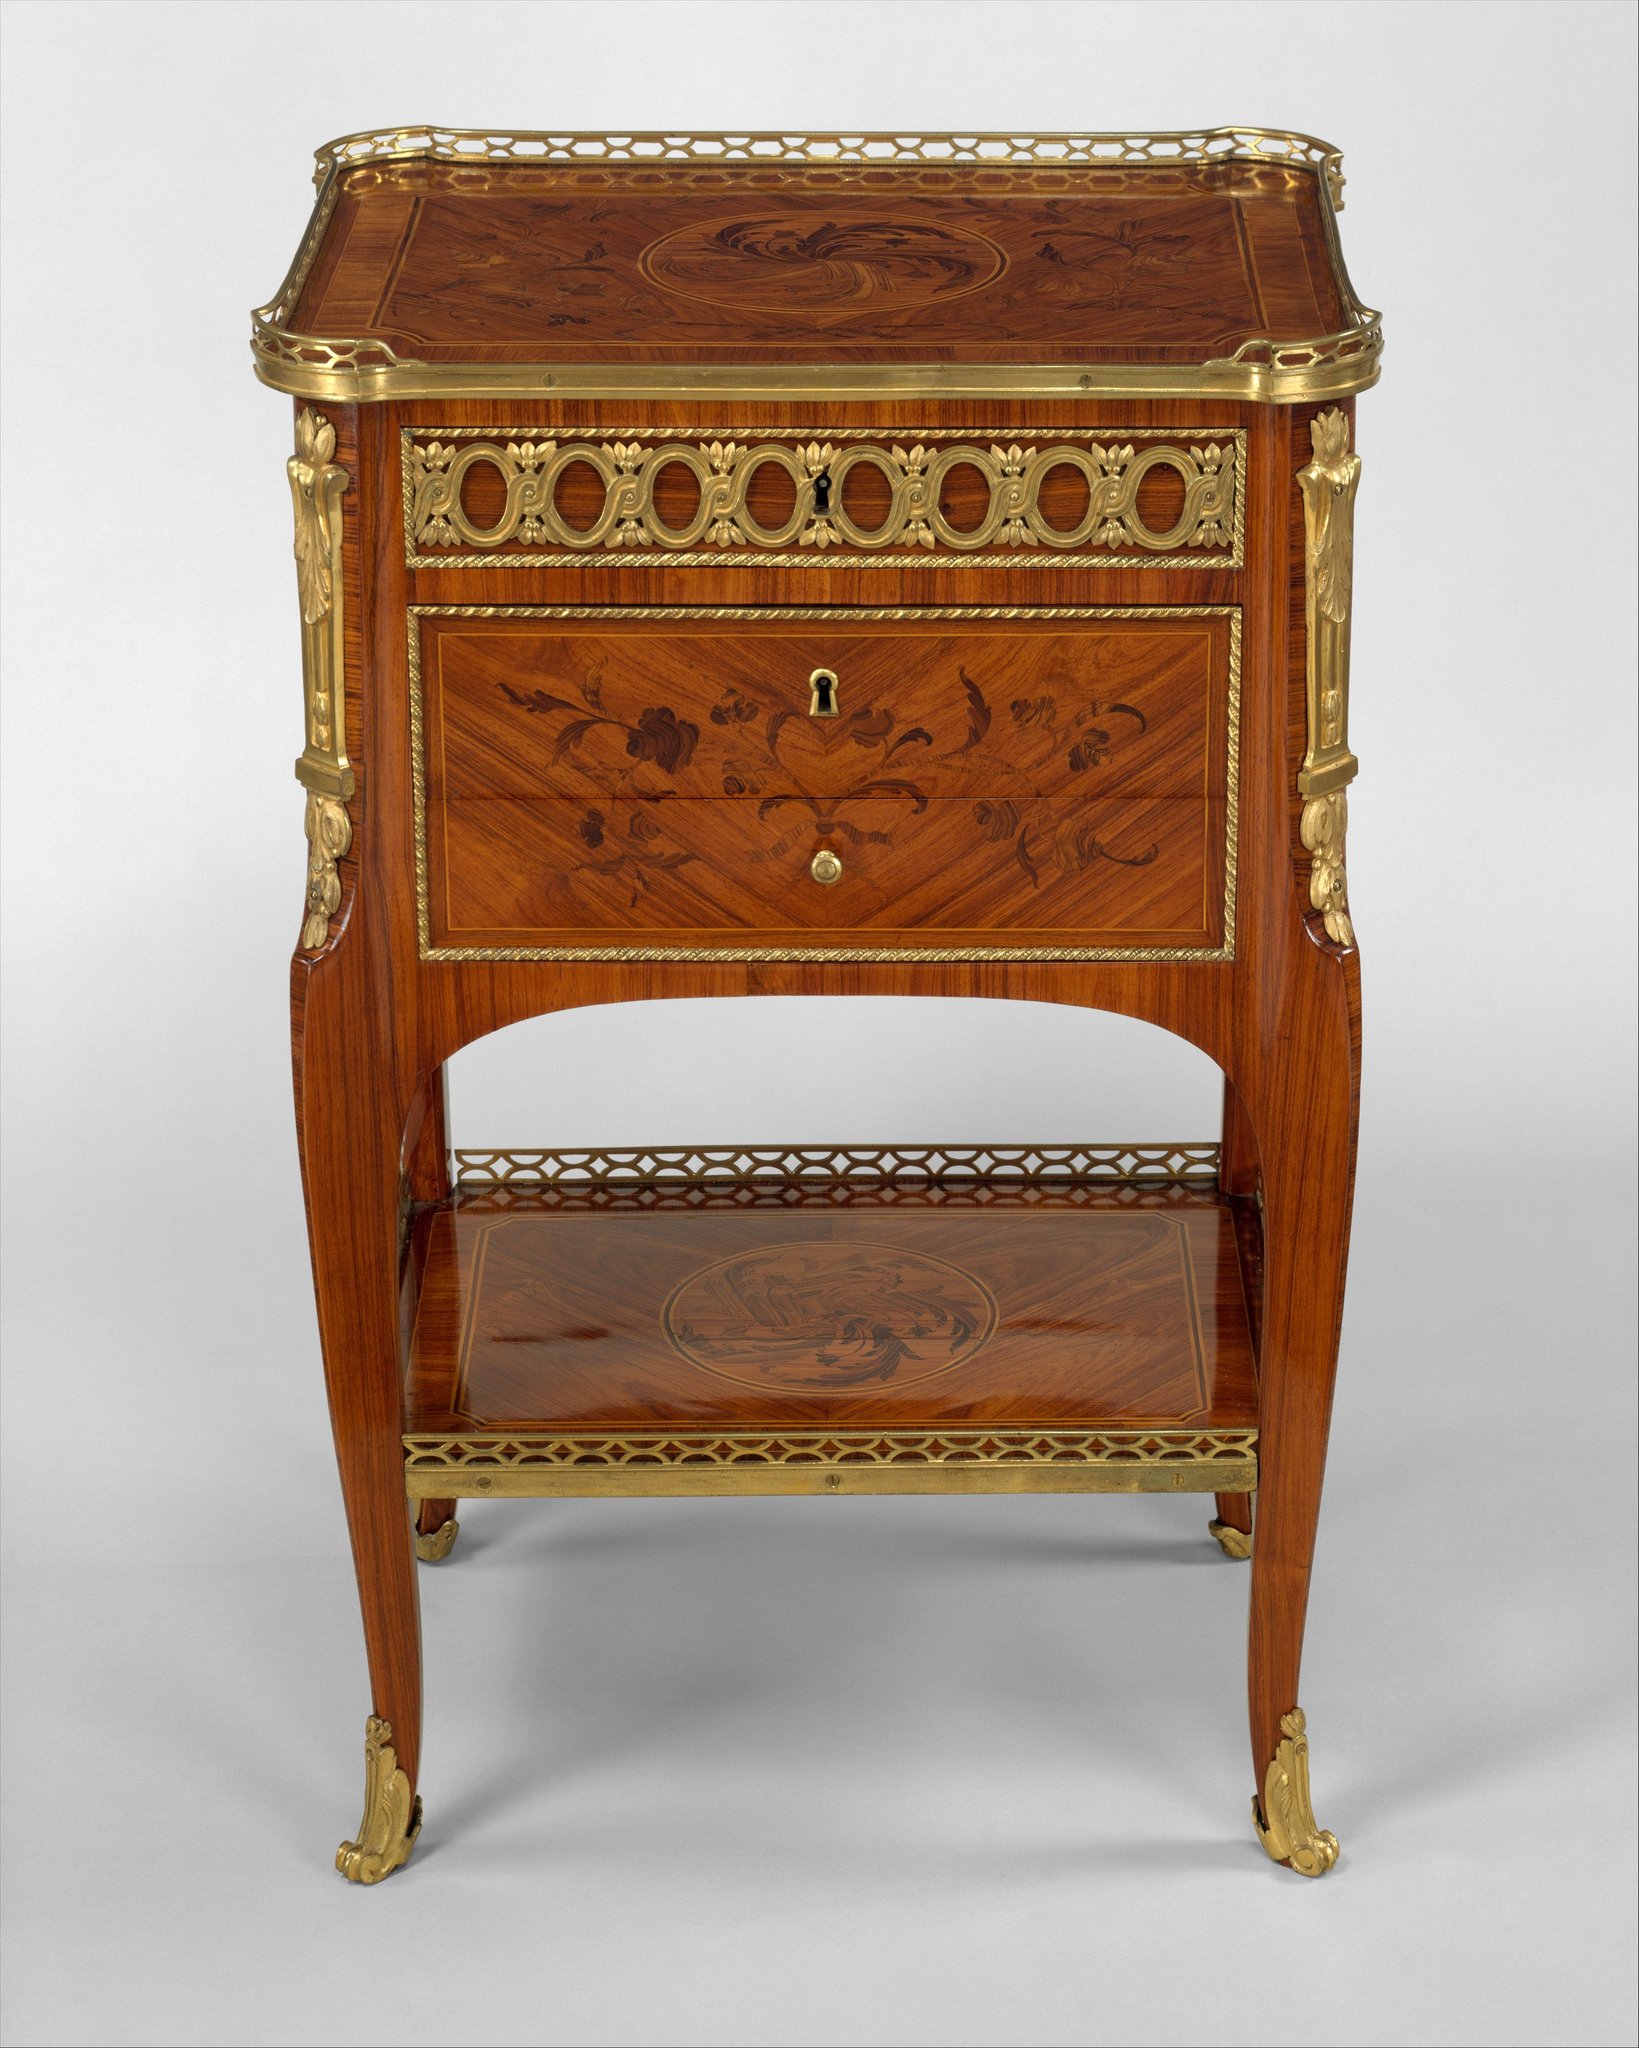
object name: writing table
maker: roger vandercruse, called lacroix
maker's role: maker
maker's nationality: french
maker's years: 1727-1799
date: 1760-1770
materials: gilt bronze, wood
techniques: veneering